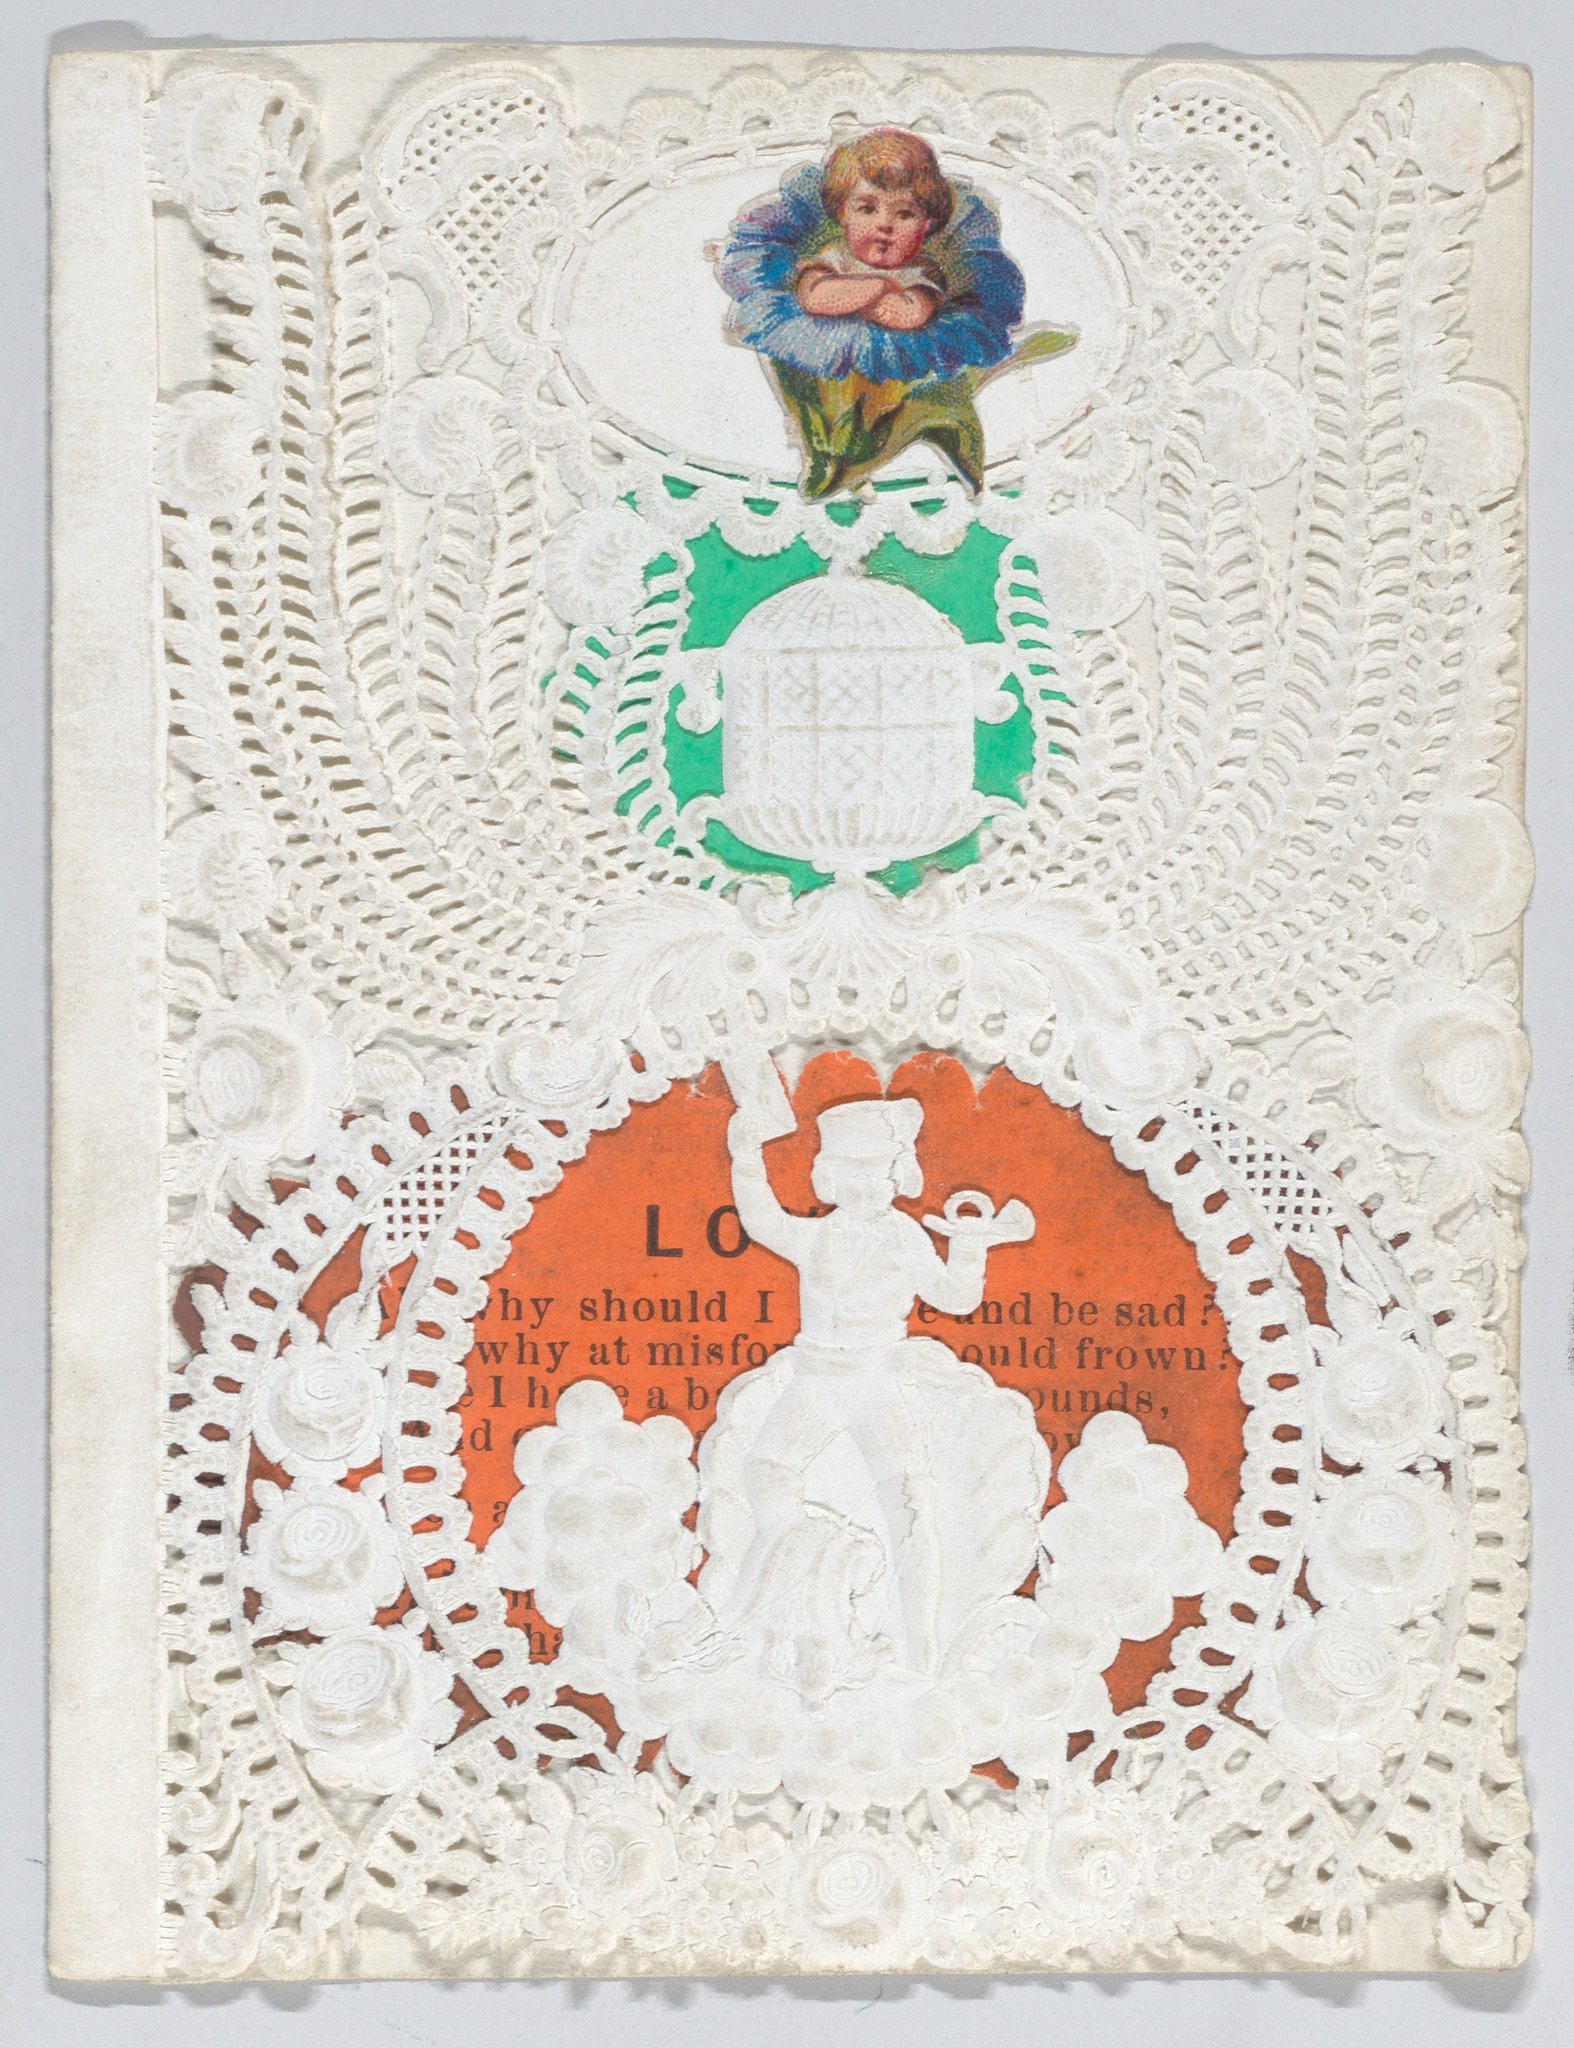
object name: valentine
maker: Anonymous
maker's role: artist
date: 1847-1870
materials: graphite, lace, paper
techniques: chromolithography, embossing, open work